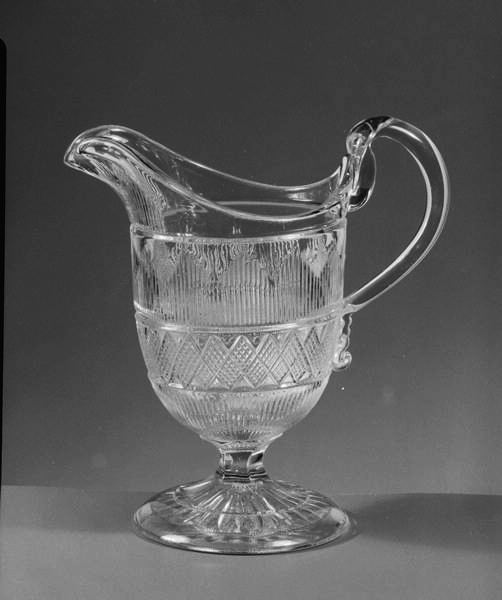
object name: cream pot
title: Creamer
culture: american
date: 1865-1875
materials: glass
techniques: pressed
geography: united states